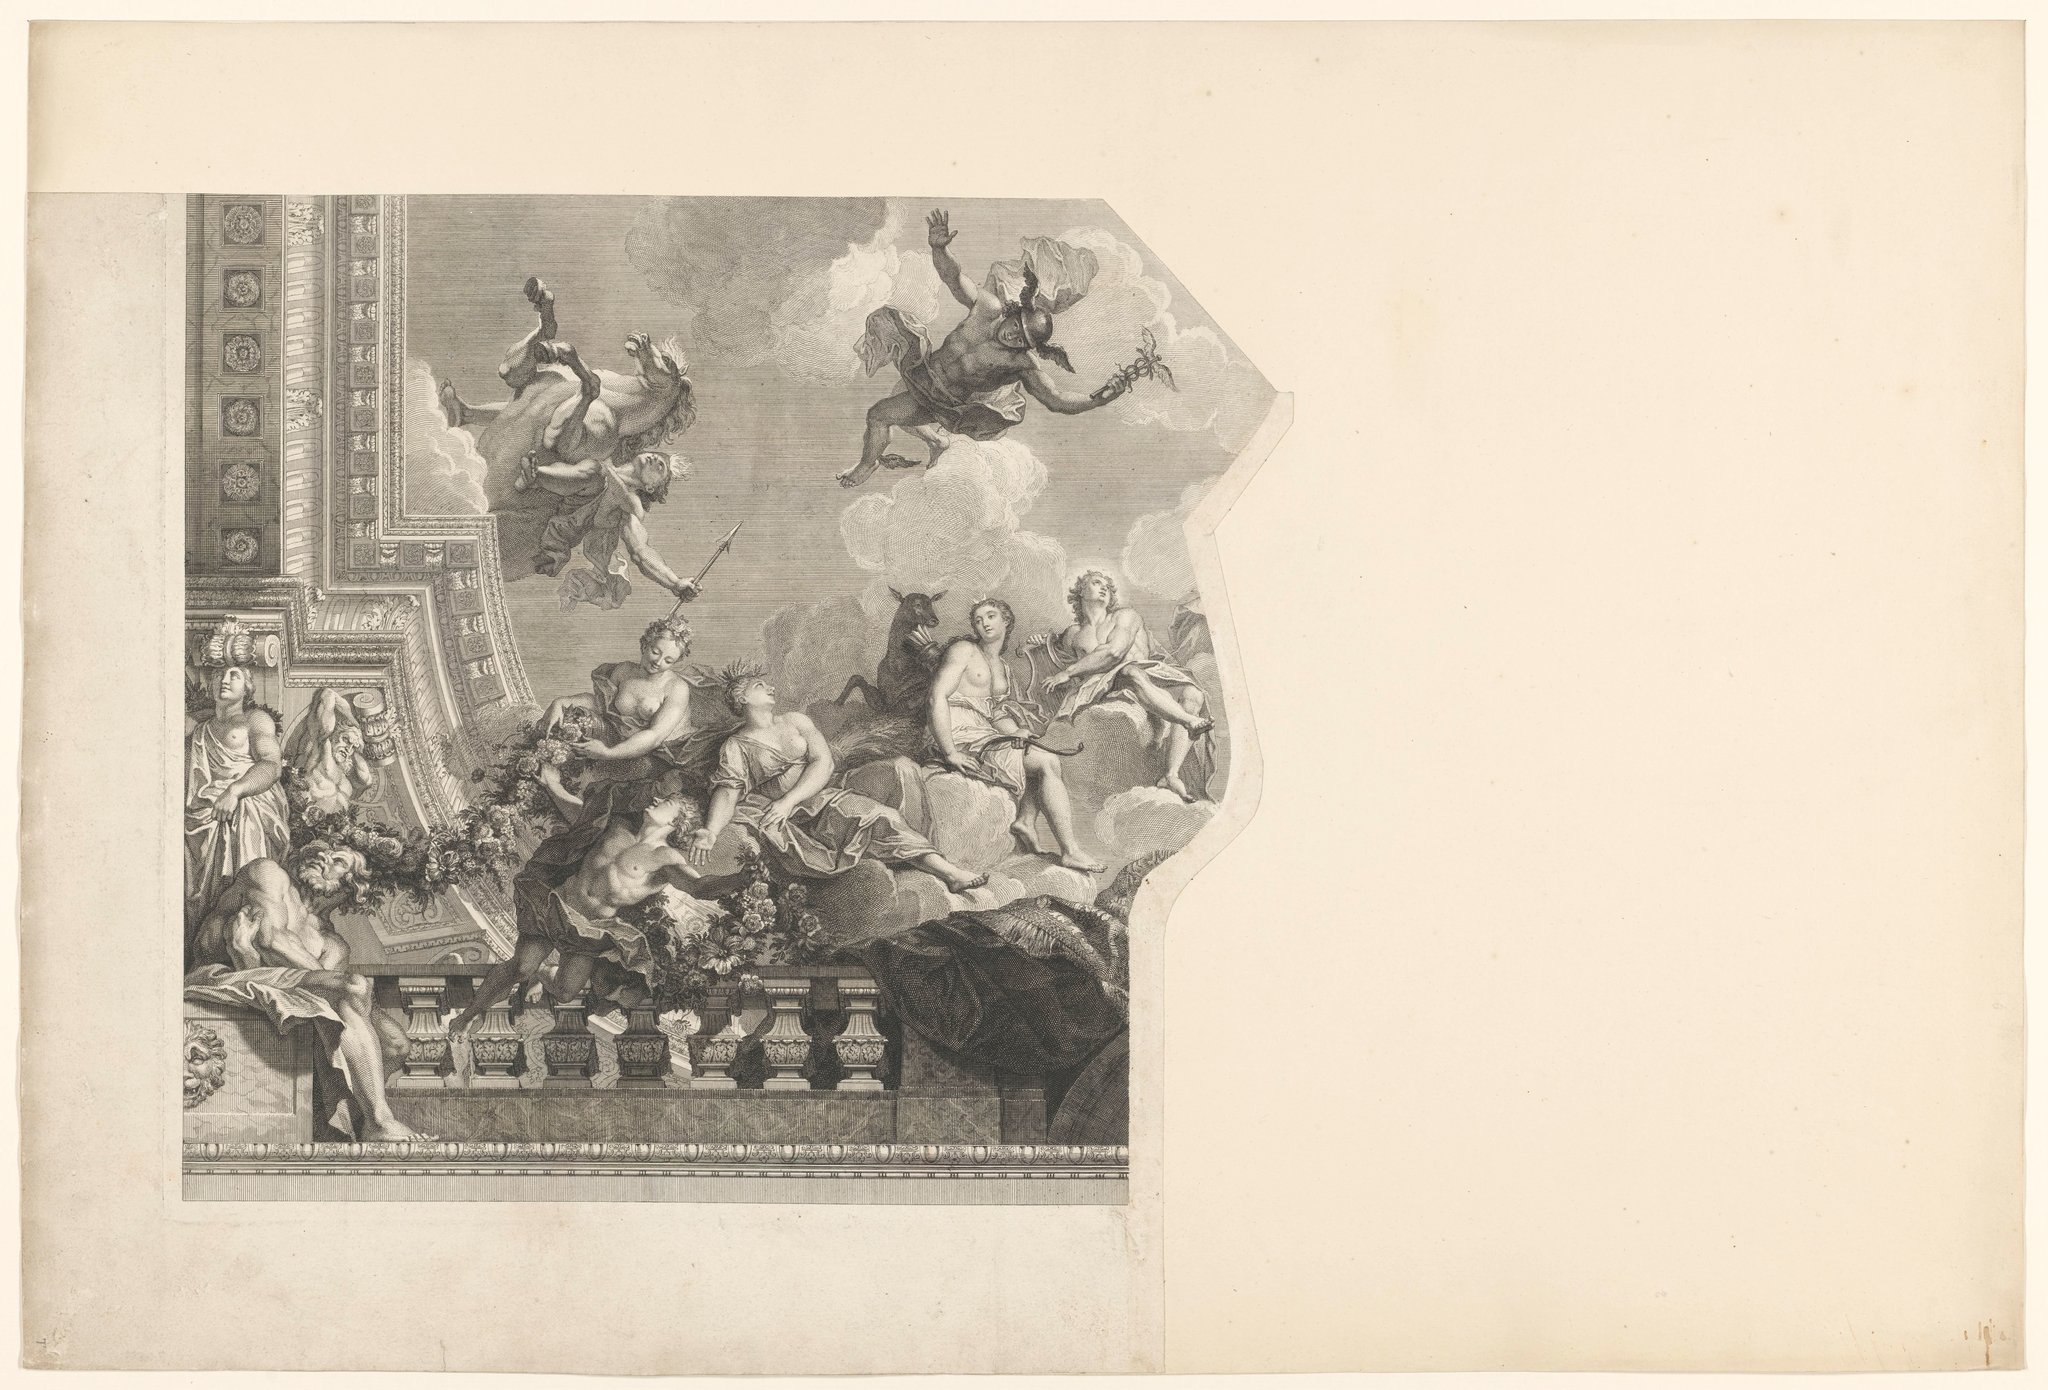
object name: print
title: Plafond du Milieu de la Grande Gallerie du Palais Royal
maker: nicolas henri tardieu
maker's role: print maker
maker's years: 1674-1749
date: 1717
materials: paper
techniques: engraving, etching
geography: france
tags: roman deities, and foreign deities included in the classical pantheon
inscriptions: collector's mark: Lugt 240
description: Plafondschildering in de Grand Galerie van het Palais-Royal.